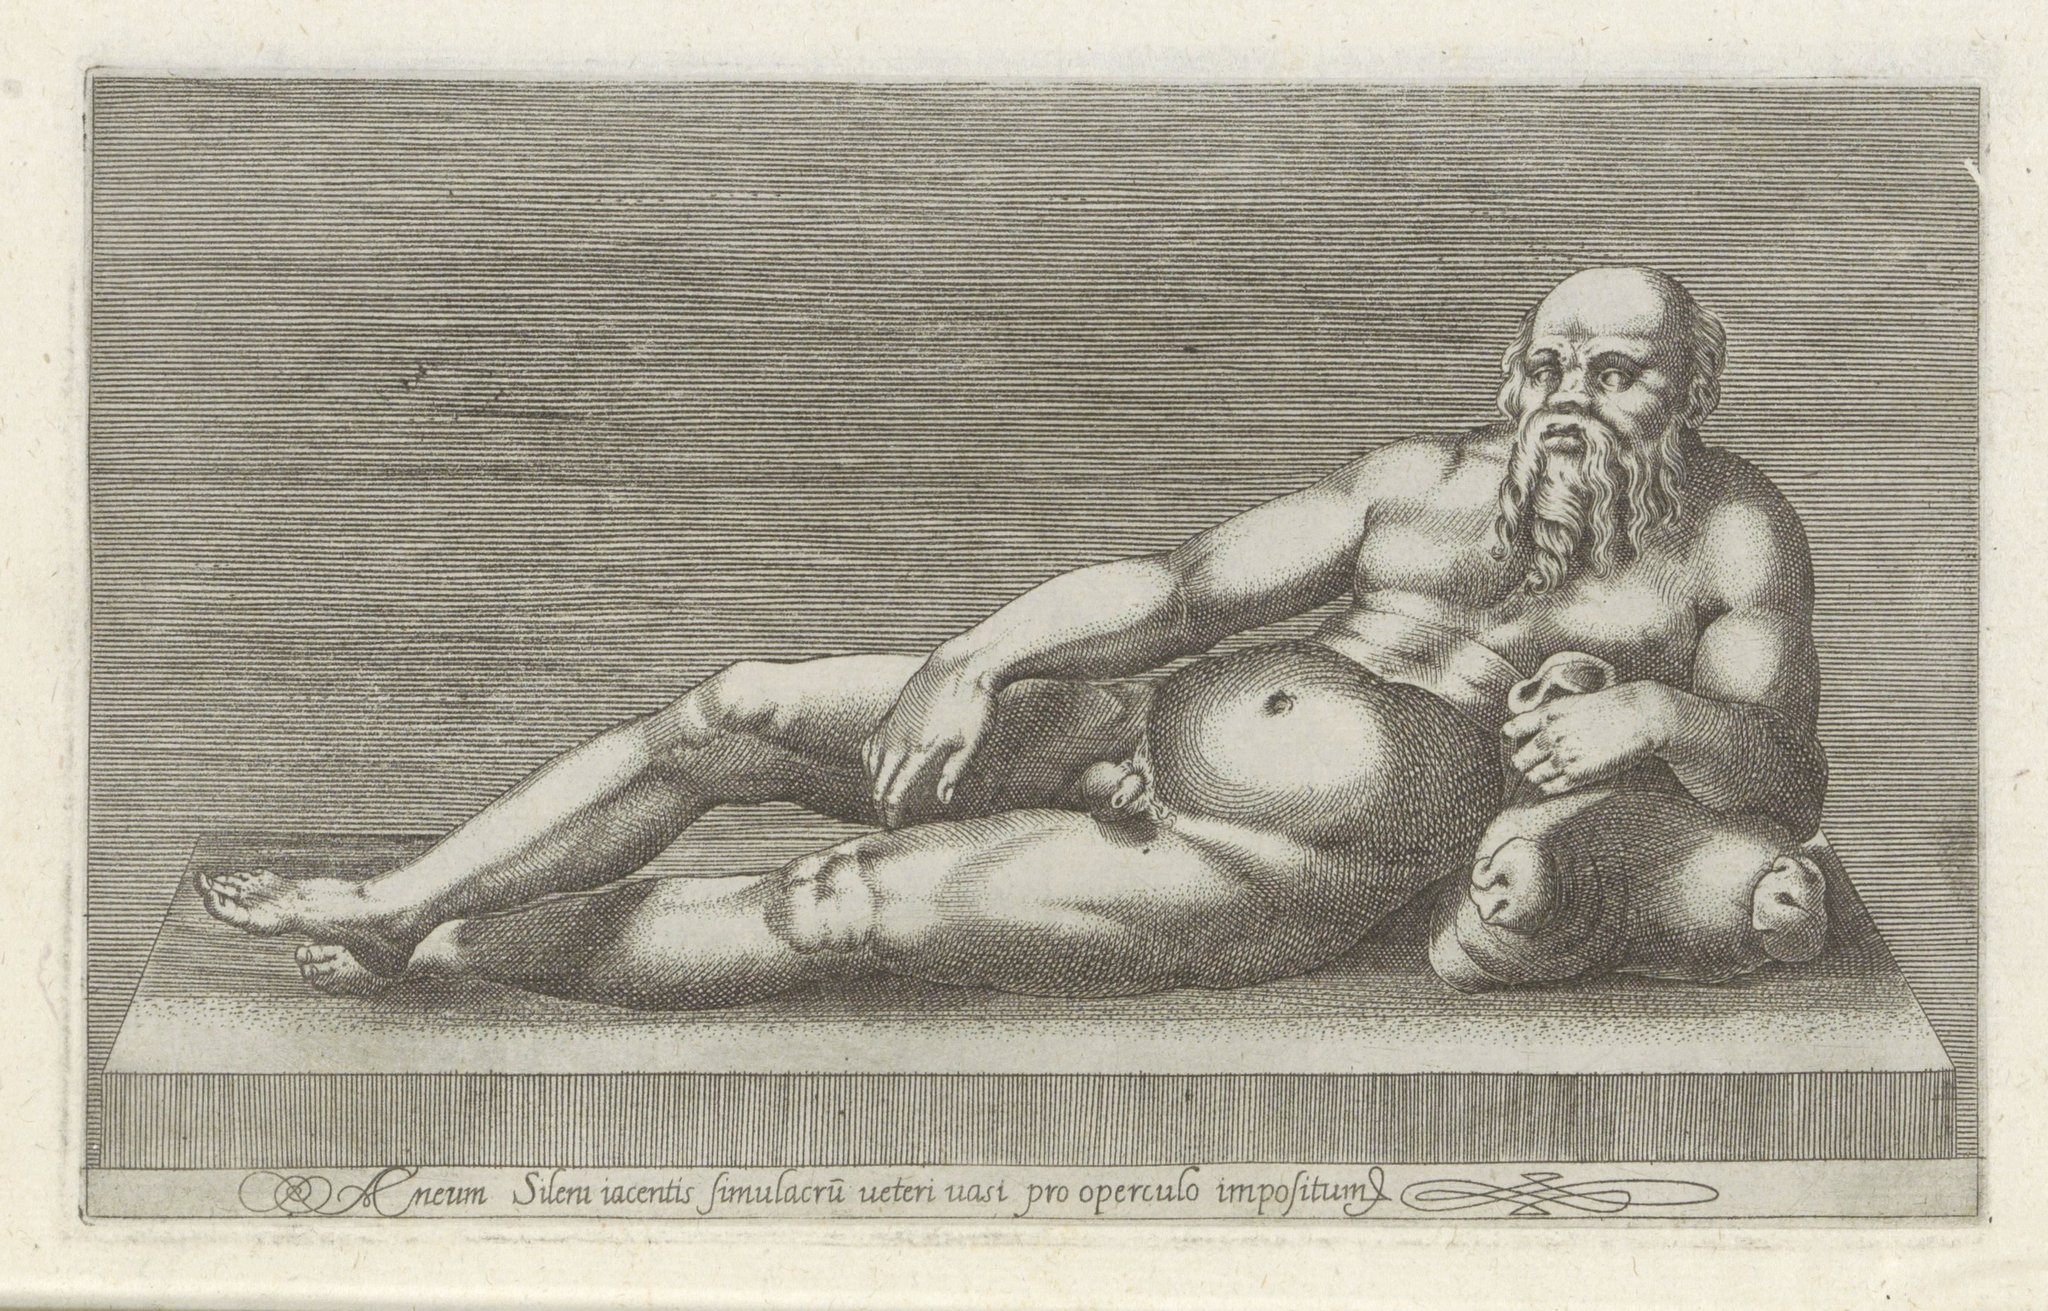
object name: print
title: Sculptuur van Silenus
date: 1584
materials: paper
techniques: engraving, intaglio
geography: rome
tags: (story of) silenus, piece of sculpture, reproduction of a piece of sculpture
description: Deze prent maakt deel uit van een set van 79 prenten (+ titelprent) met voorstellingen van antieke sculpturen in Rome.